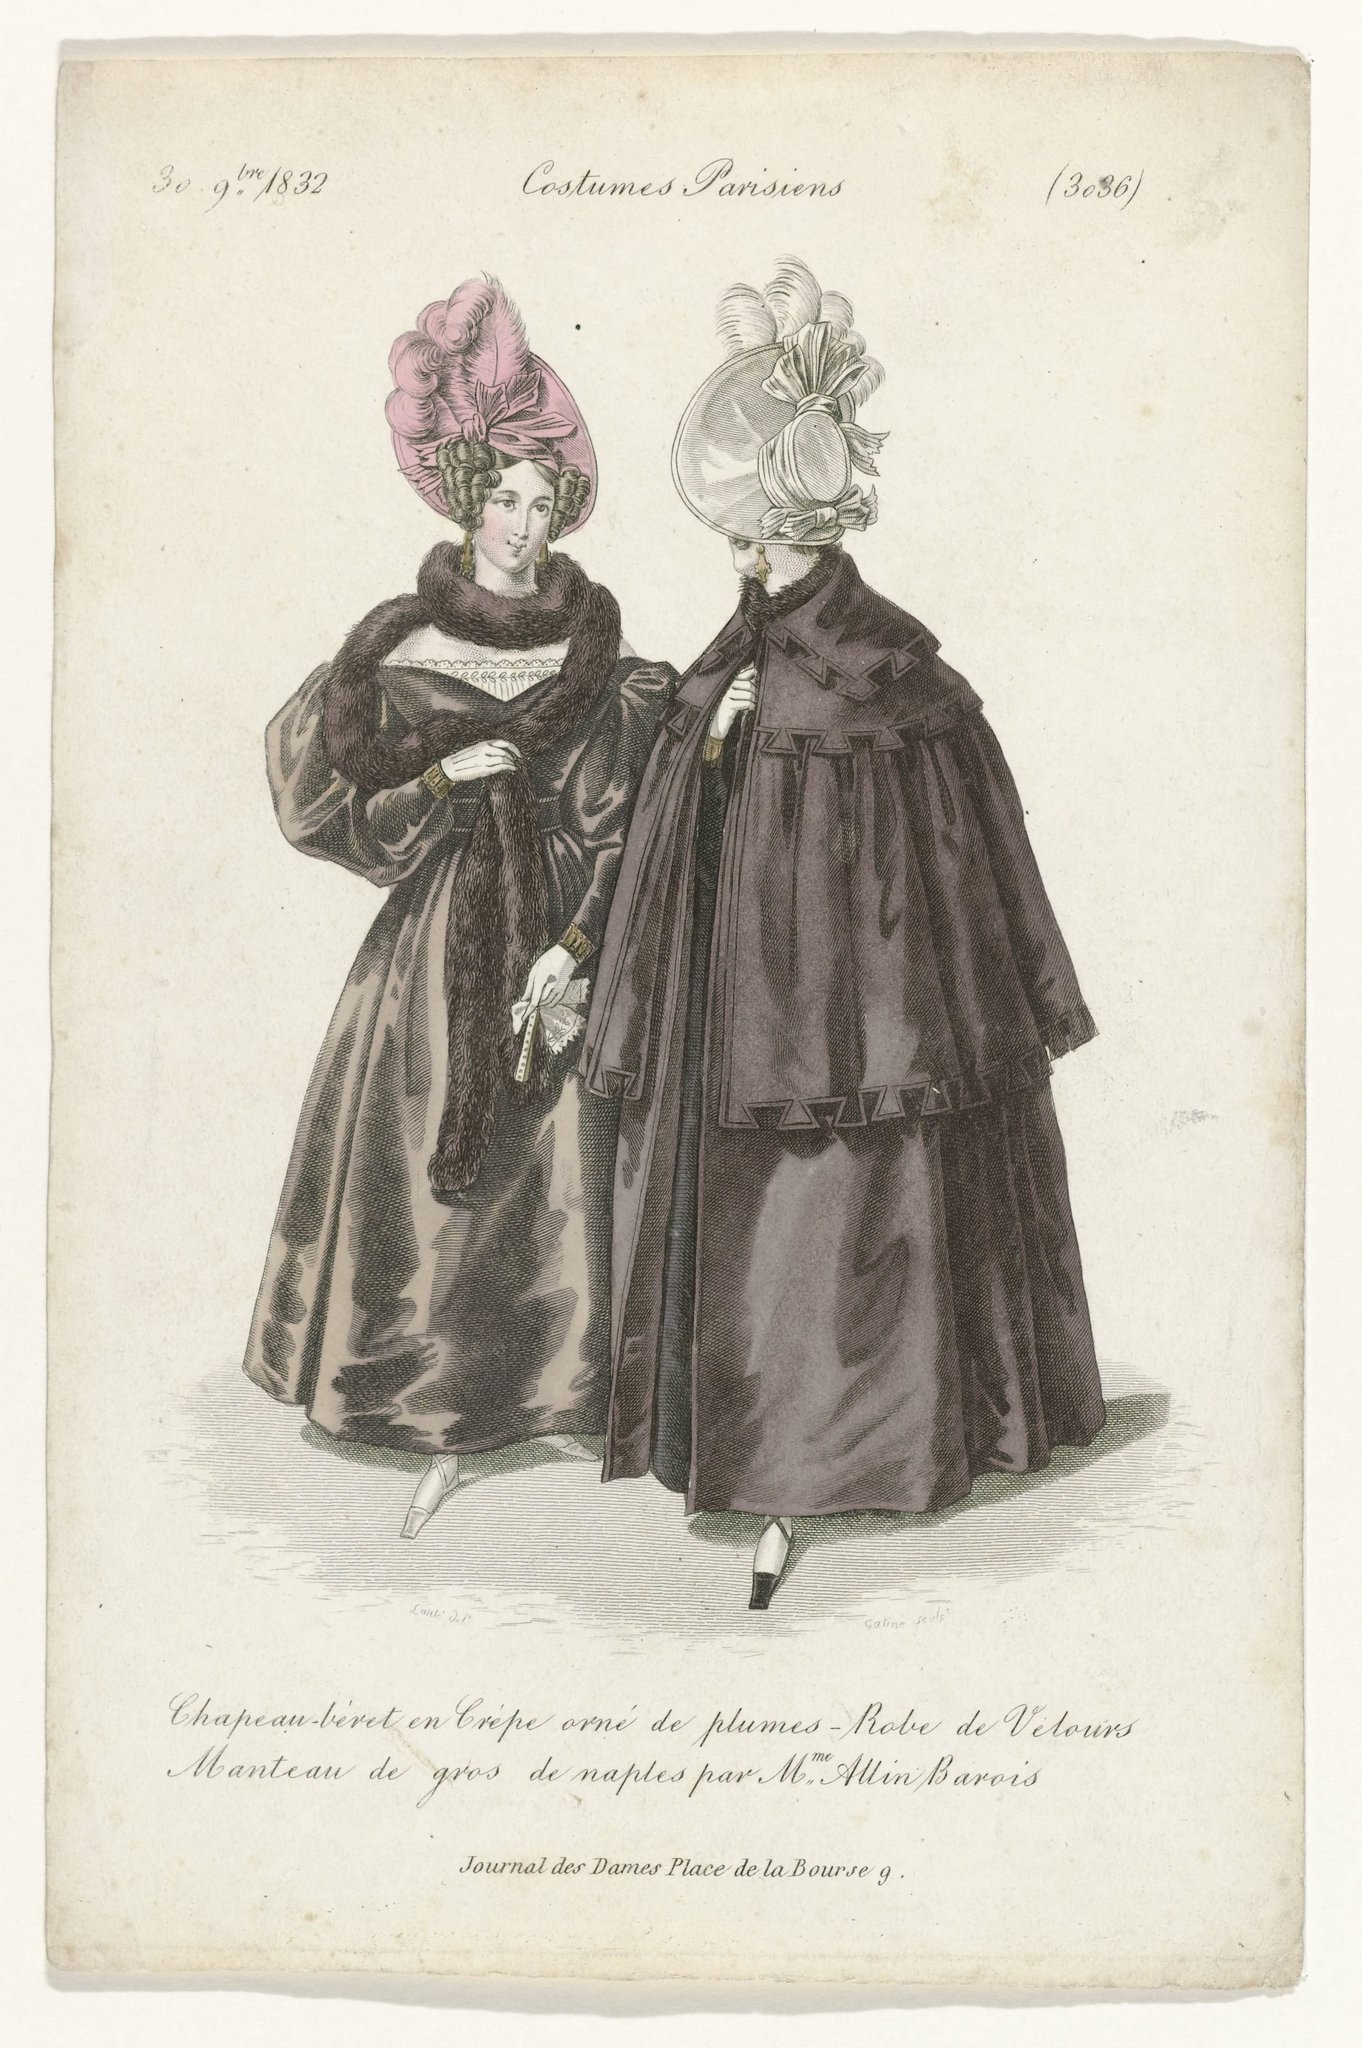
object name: fashion print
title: Journal des Dames et des Modes, Costumes Parisiens, 30 novembre 1832, (3036): Chapeau-béret (...)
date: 1832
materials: paper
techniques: engraving, hand coloring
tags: coat (+ women's clothes), fashion plates, head-gear: hat (+ women's clothes), dress, gown (+ women's clothes), clothing for the upper part of the body (shawl) (+ fur used for clothes)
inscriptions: address: ‘Journal des Dames Place de la Bourse 9.’, title: ‘Costumes Parisiens.’, caption: ‘Chapeau-béret en Crêpe orné de plumes- Robe de Velours Manteau de gros de naples par M.me Allin Barois’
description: Hoed of 'chapeau-béret' van crêpe versierd met veren. Japon met schapenboutmouwen van fluweel. Mantel van 'gros de naples' door Allin Barois. Verdere accessoires: oorbellen, stola, handschoenen, armbanden, zakdoek, waaier, schoenen met vierkante neuzen. De prent maakt deel uit van het modetijdschrift Journal des Dames et des Modes, Parijs, 1797-1839.